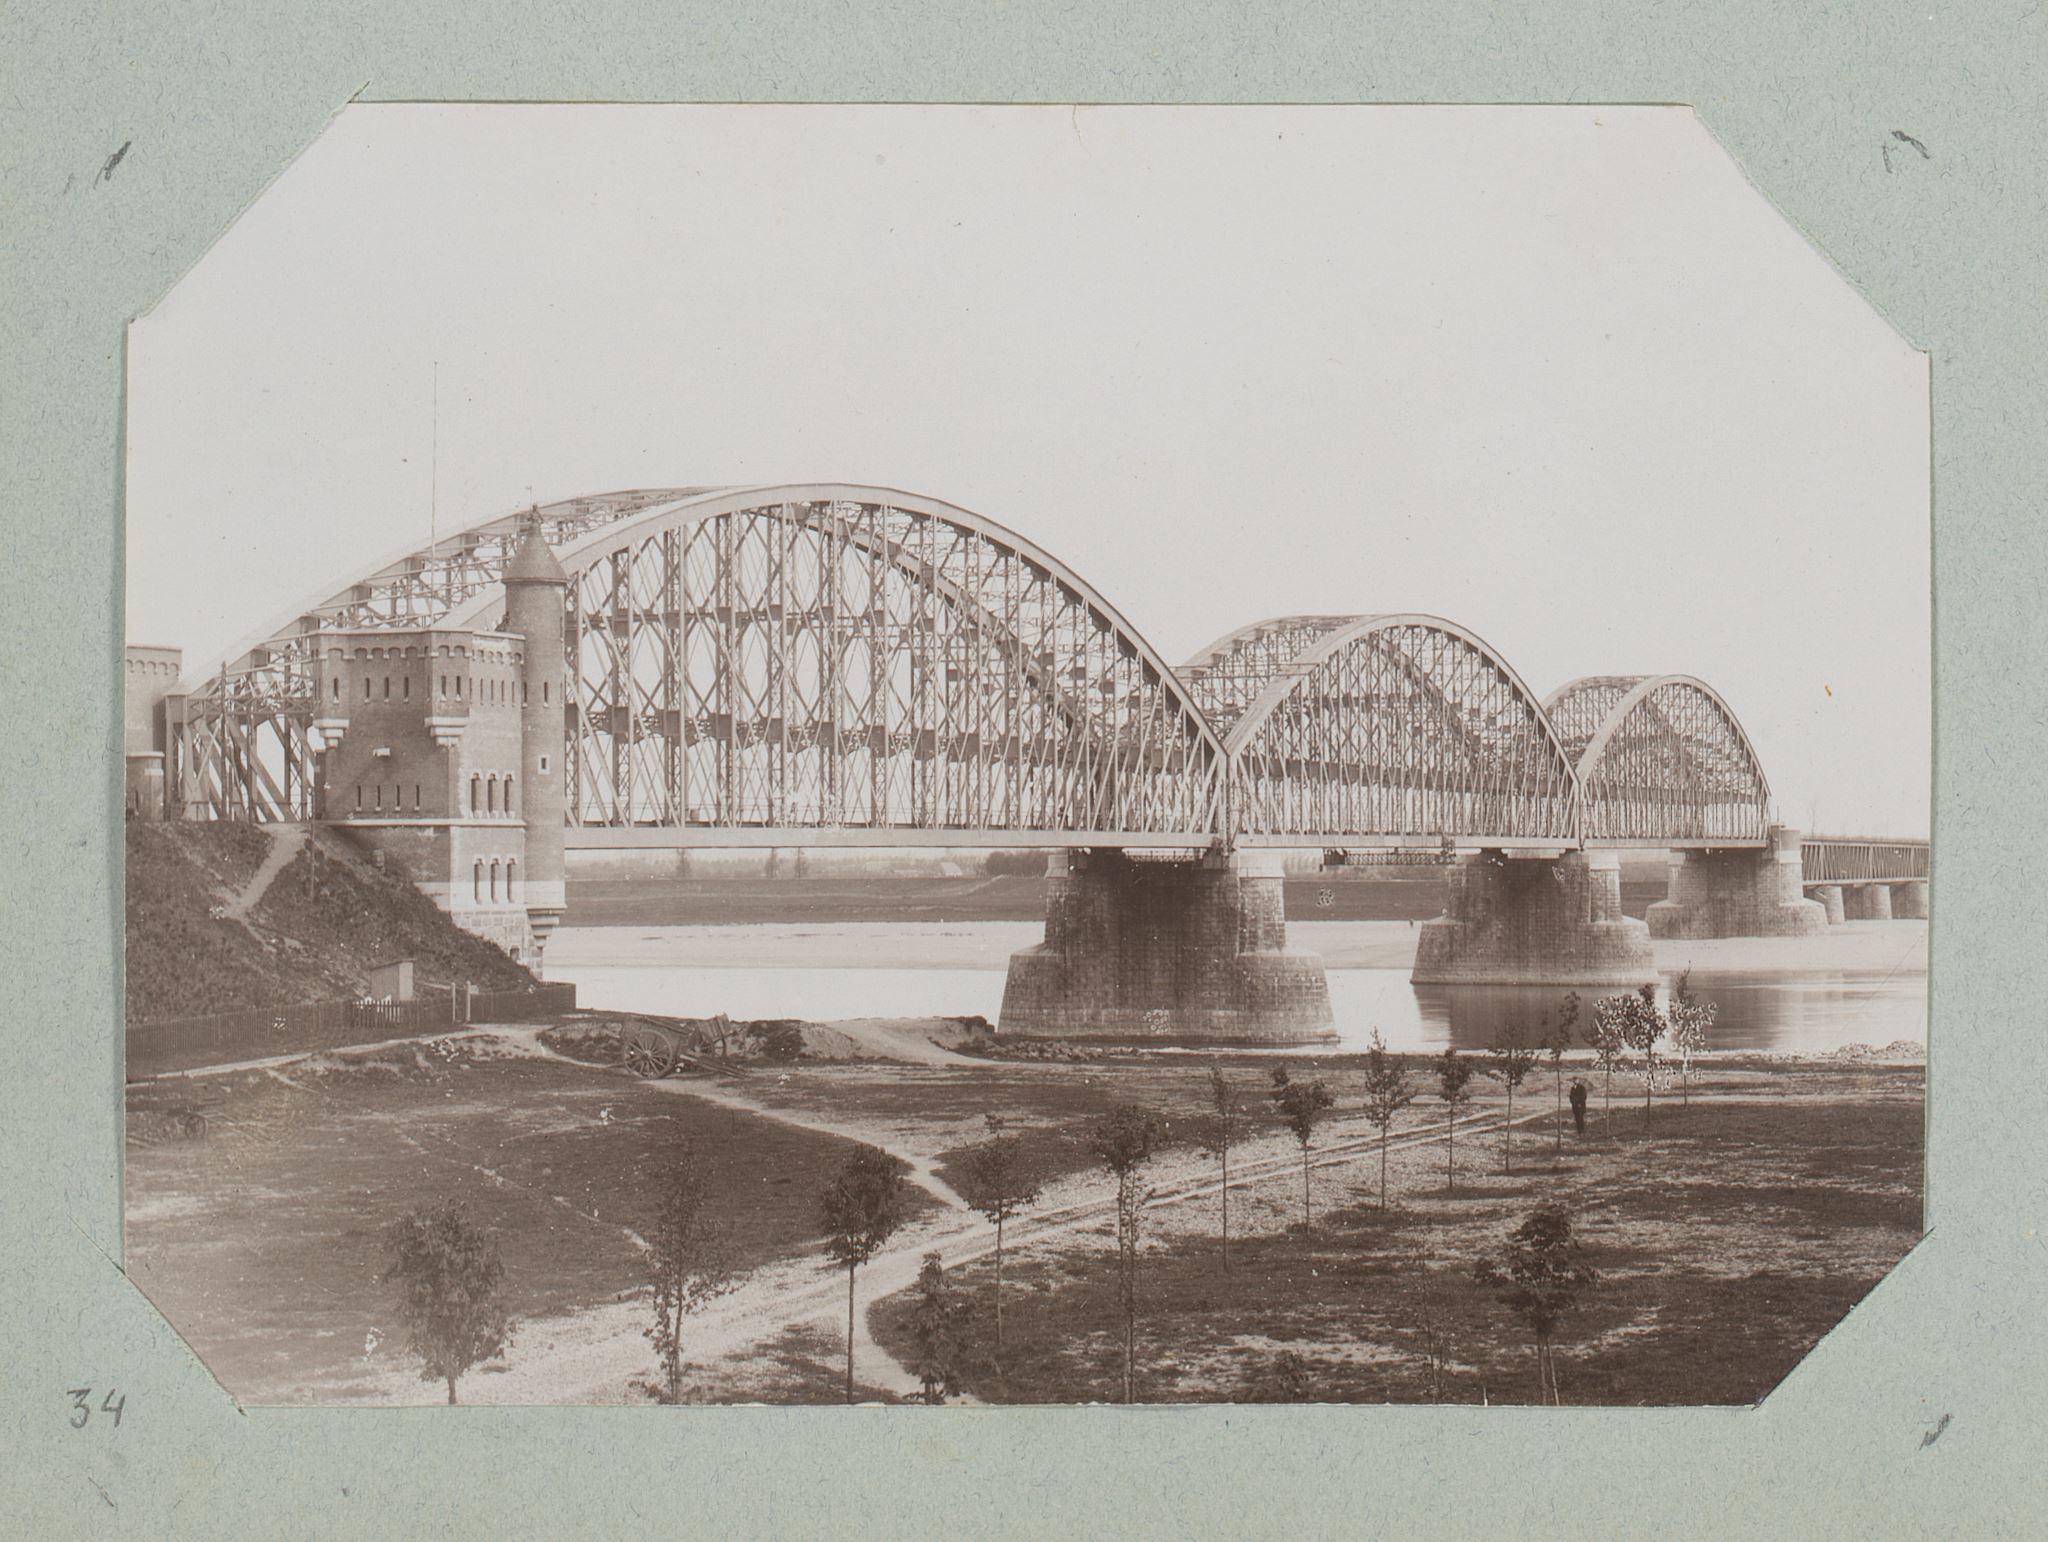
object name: photograph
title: Spoorbrug over de Waal bij Nijmegen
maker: Anonymous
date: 1895-1905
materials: paper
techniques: collodion silver print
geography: nijmegen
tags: bridge, nijmegen